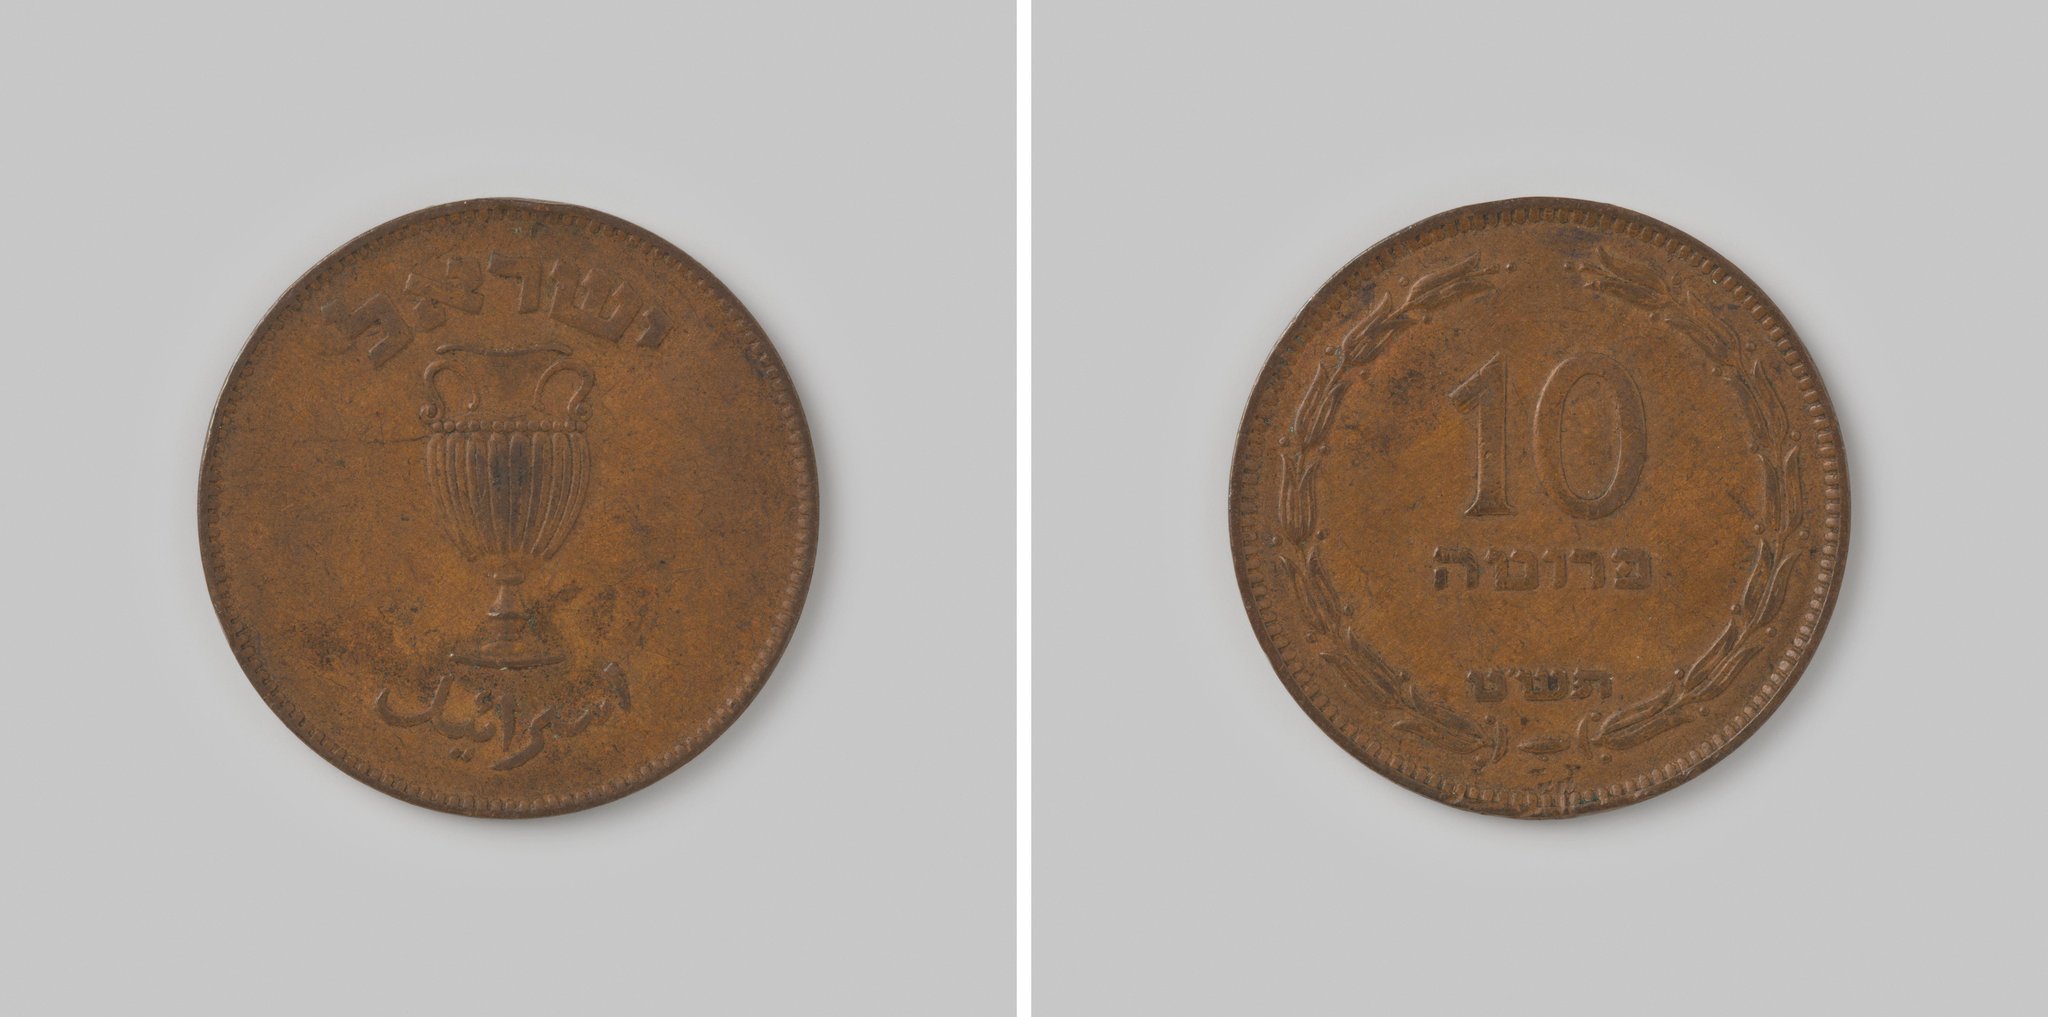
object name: coin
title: Israël, 10 pruta, 5709 [=1949]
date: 1949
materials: bronze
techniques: striking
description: Bronzen munt. Voorzijde: vaas. Daarboven lands-aanduiding in Hebreeuws schrift en daaronder lands-aanduiding in Arabisch schrift. Keerzijde: binnen twee samenkomende takken waarde-aanduiding in twee regels, waaronder jaartal: 5709. Gladde rand.